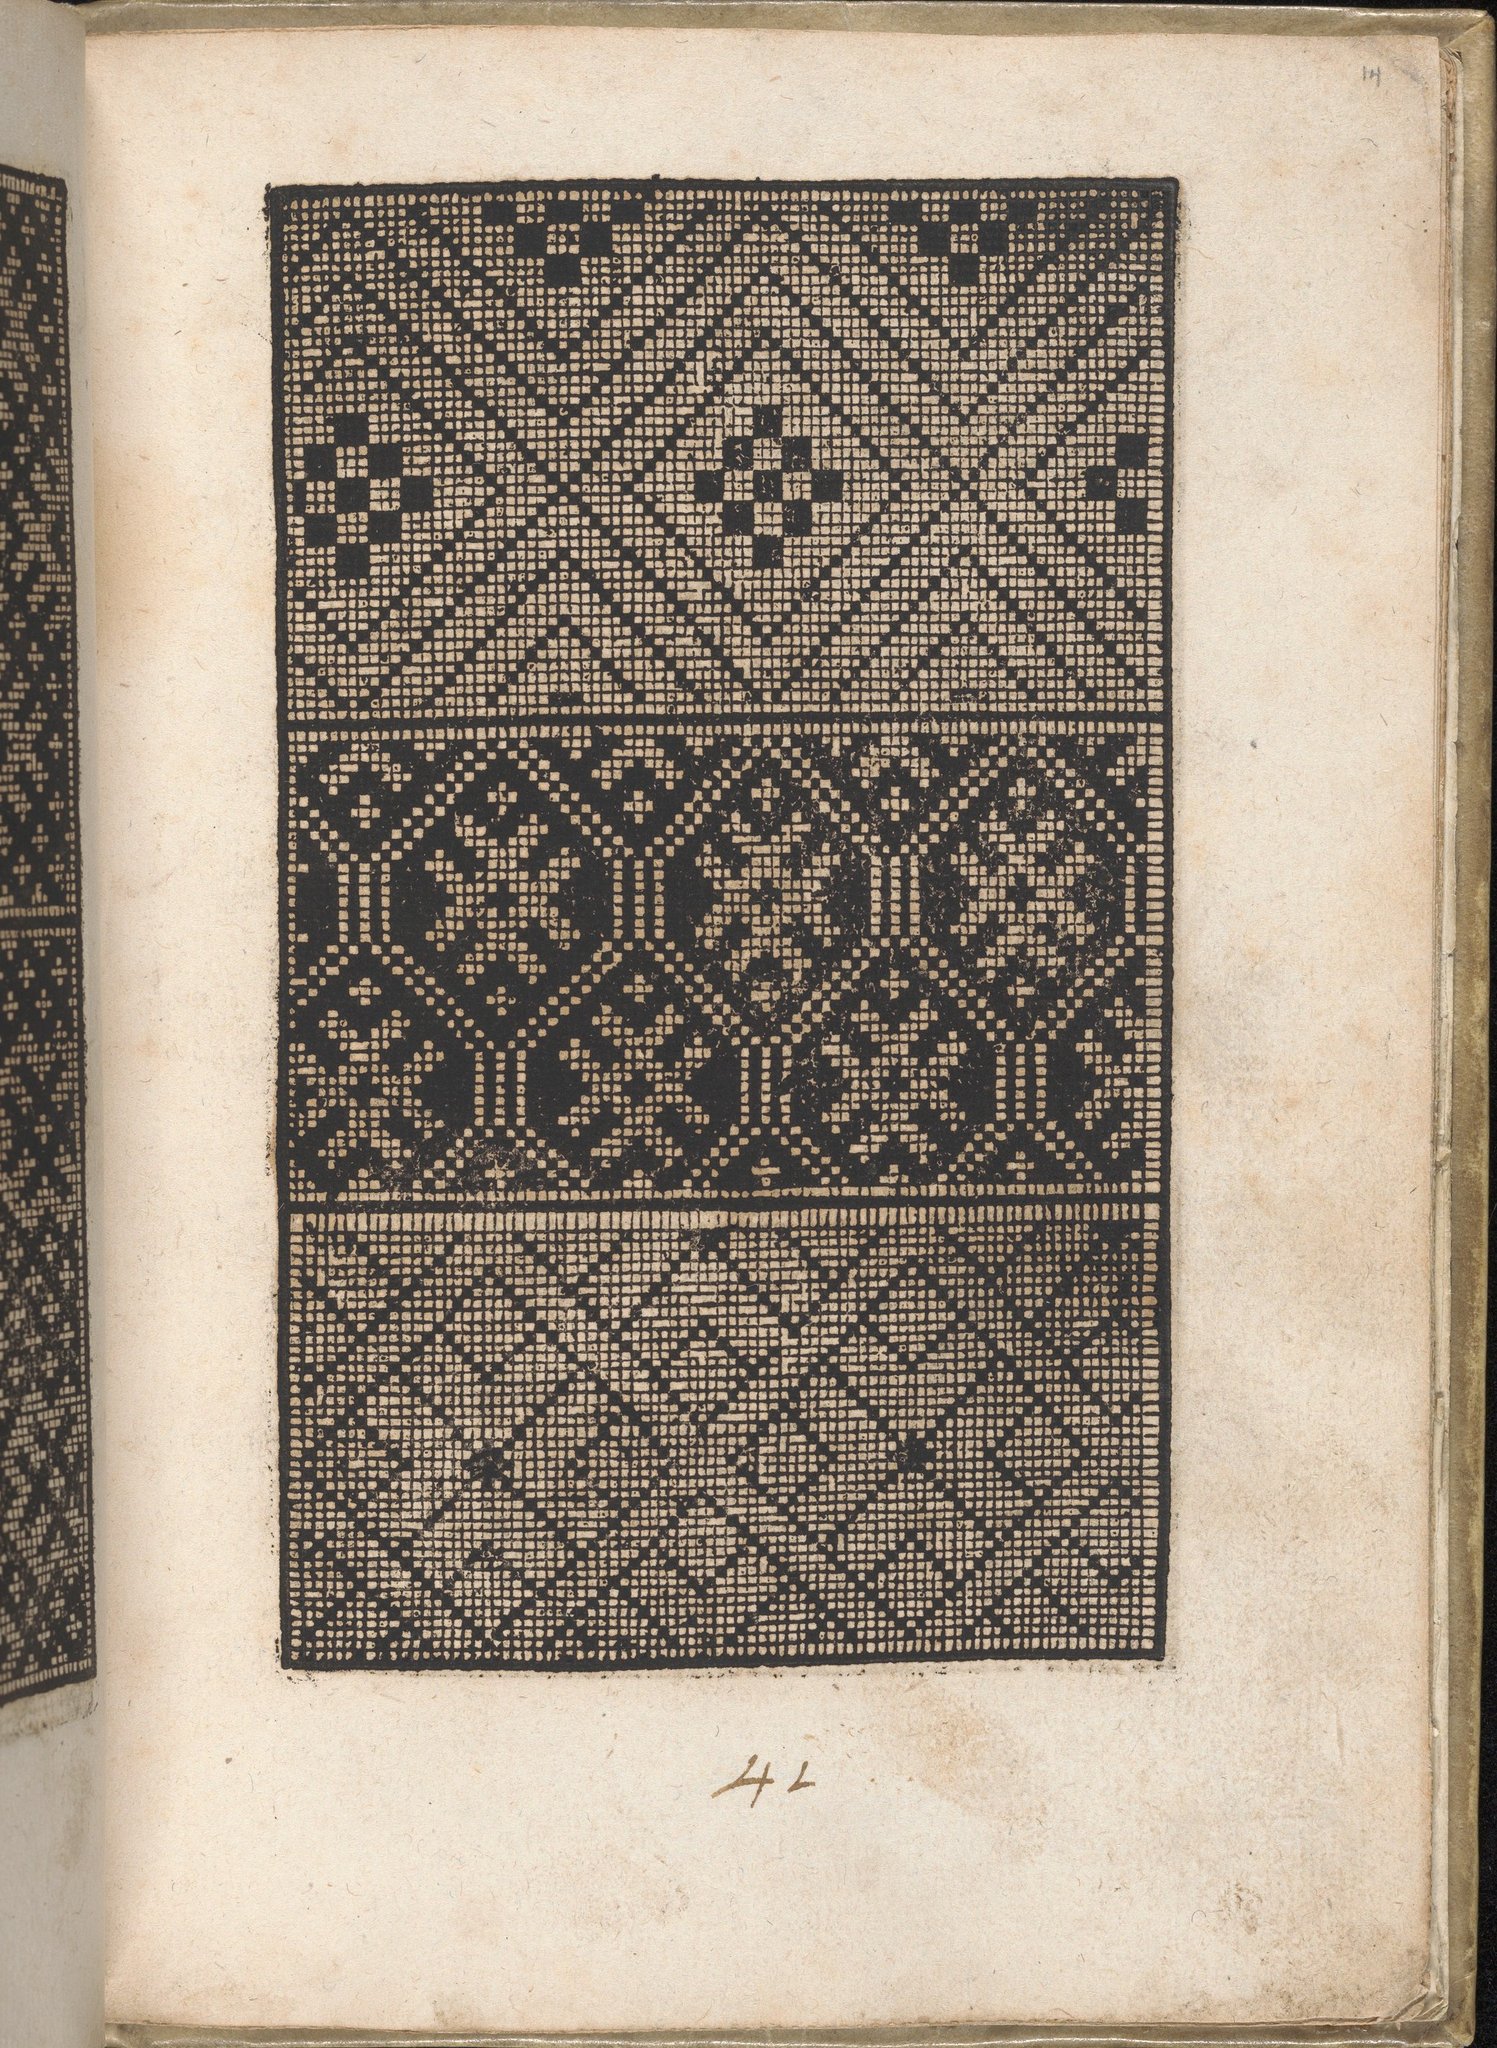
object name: book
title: Page 14v, from "Eyn New Kunstlichboich"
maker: peter quentel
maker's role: publisher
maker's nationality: german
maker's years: 1500-1550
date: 1529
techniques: woodcut